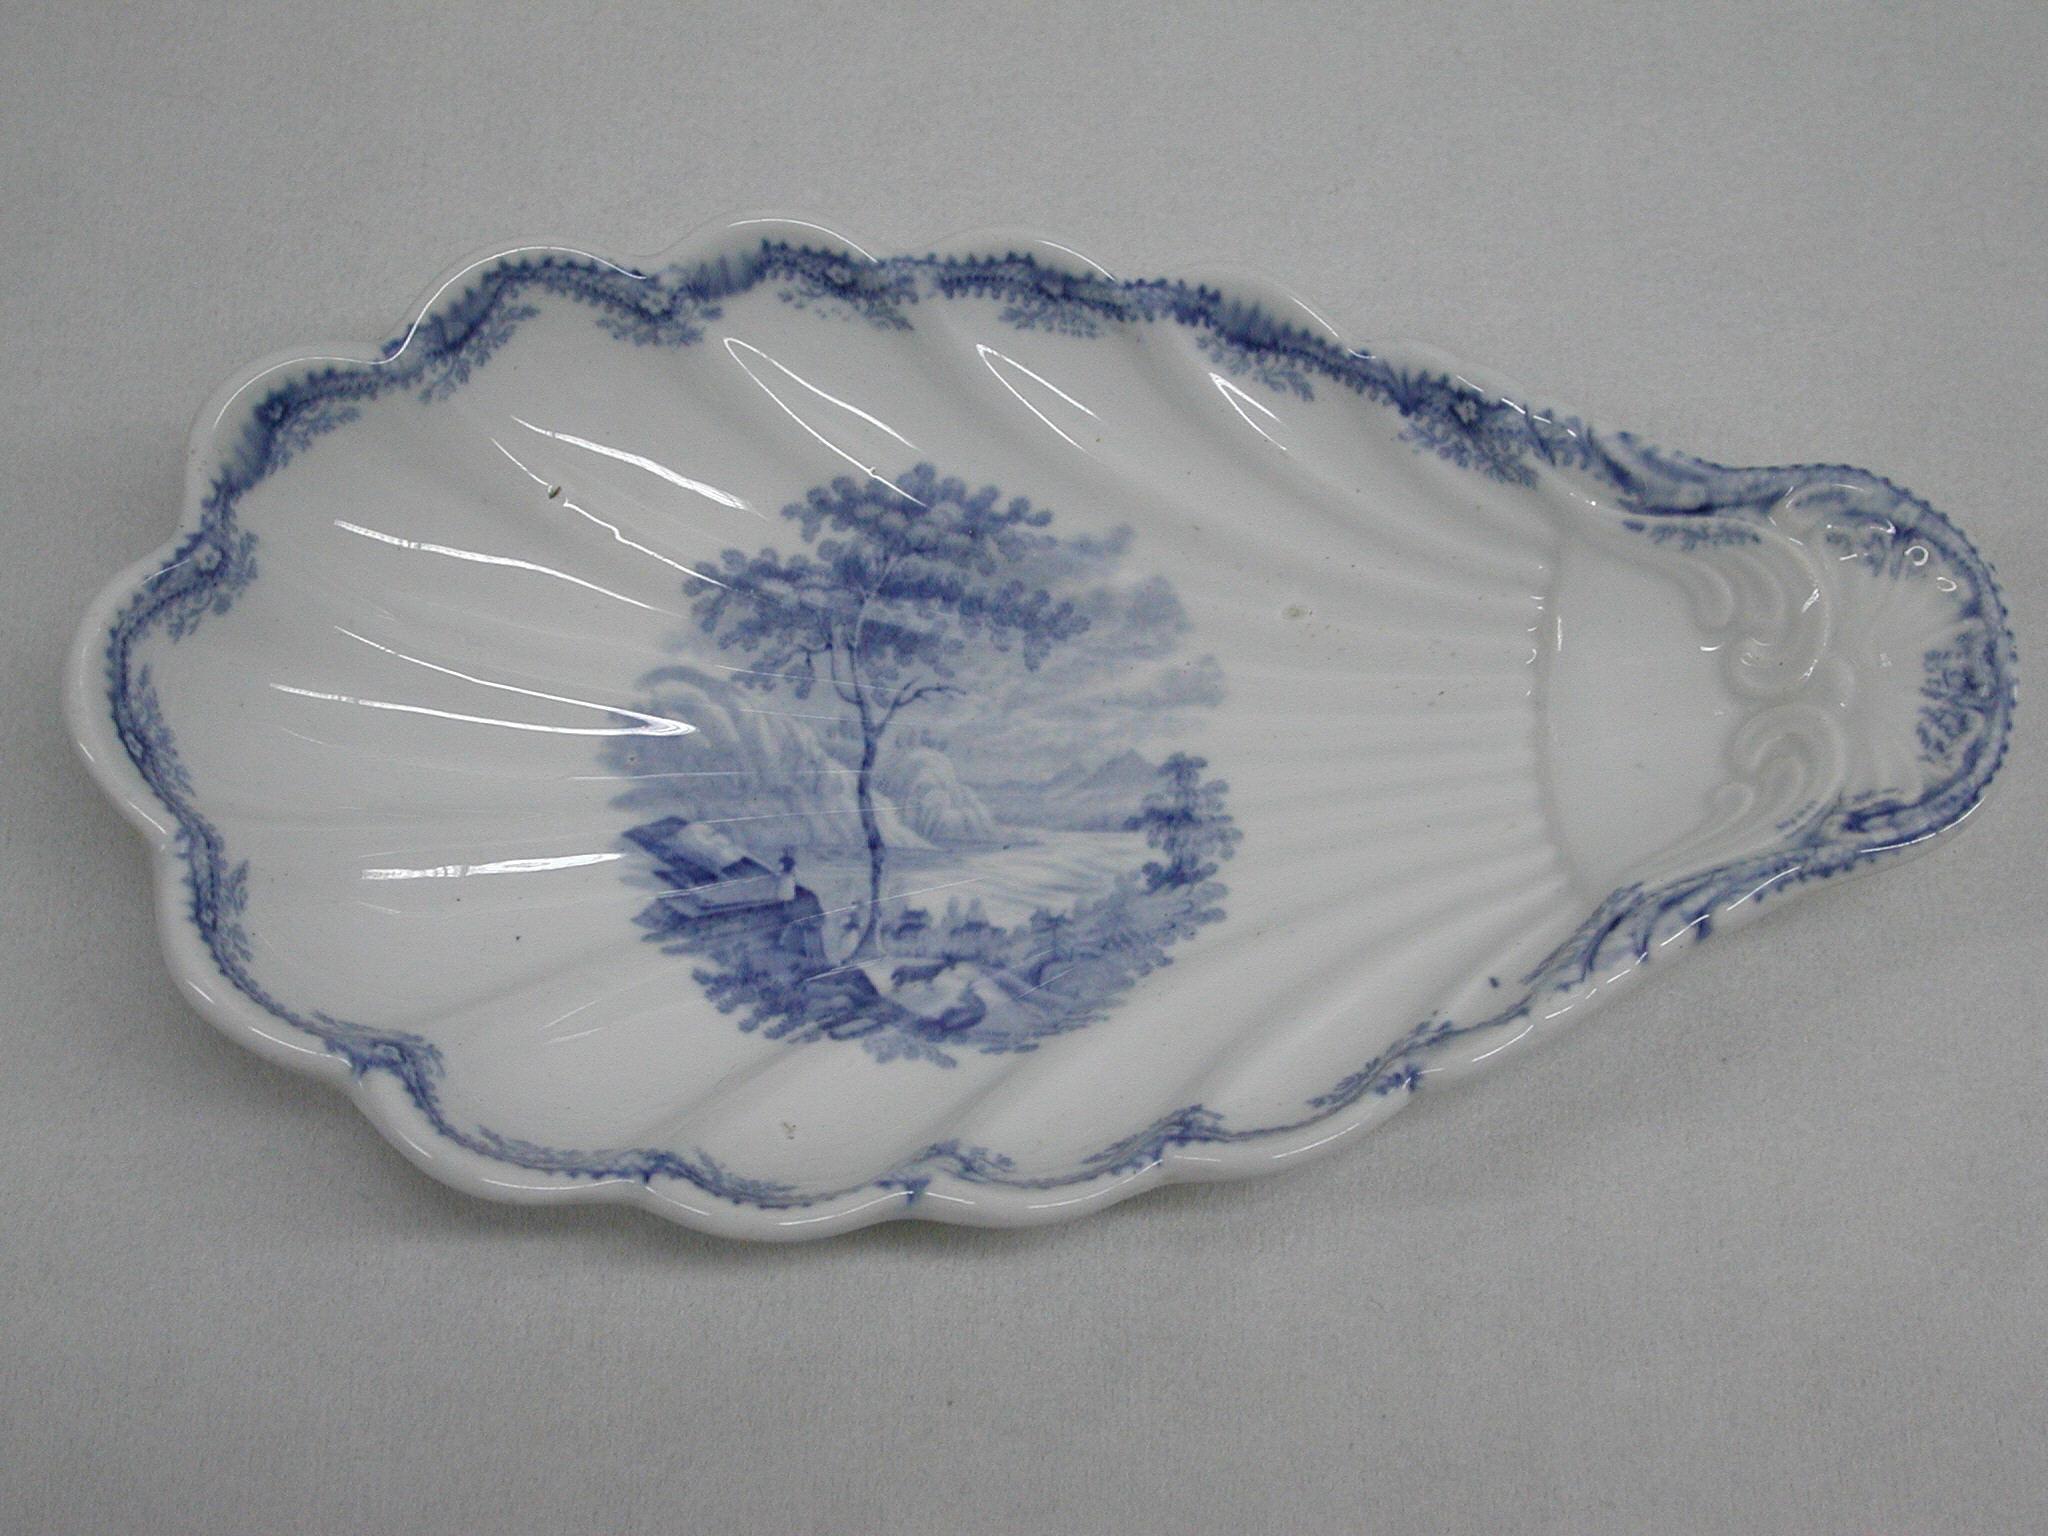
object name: dish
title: Pickle dish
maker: william ridgeway son & co.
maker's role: factory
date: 1838-1848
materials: pottery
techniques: glazing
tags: trees